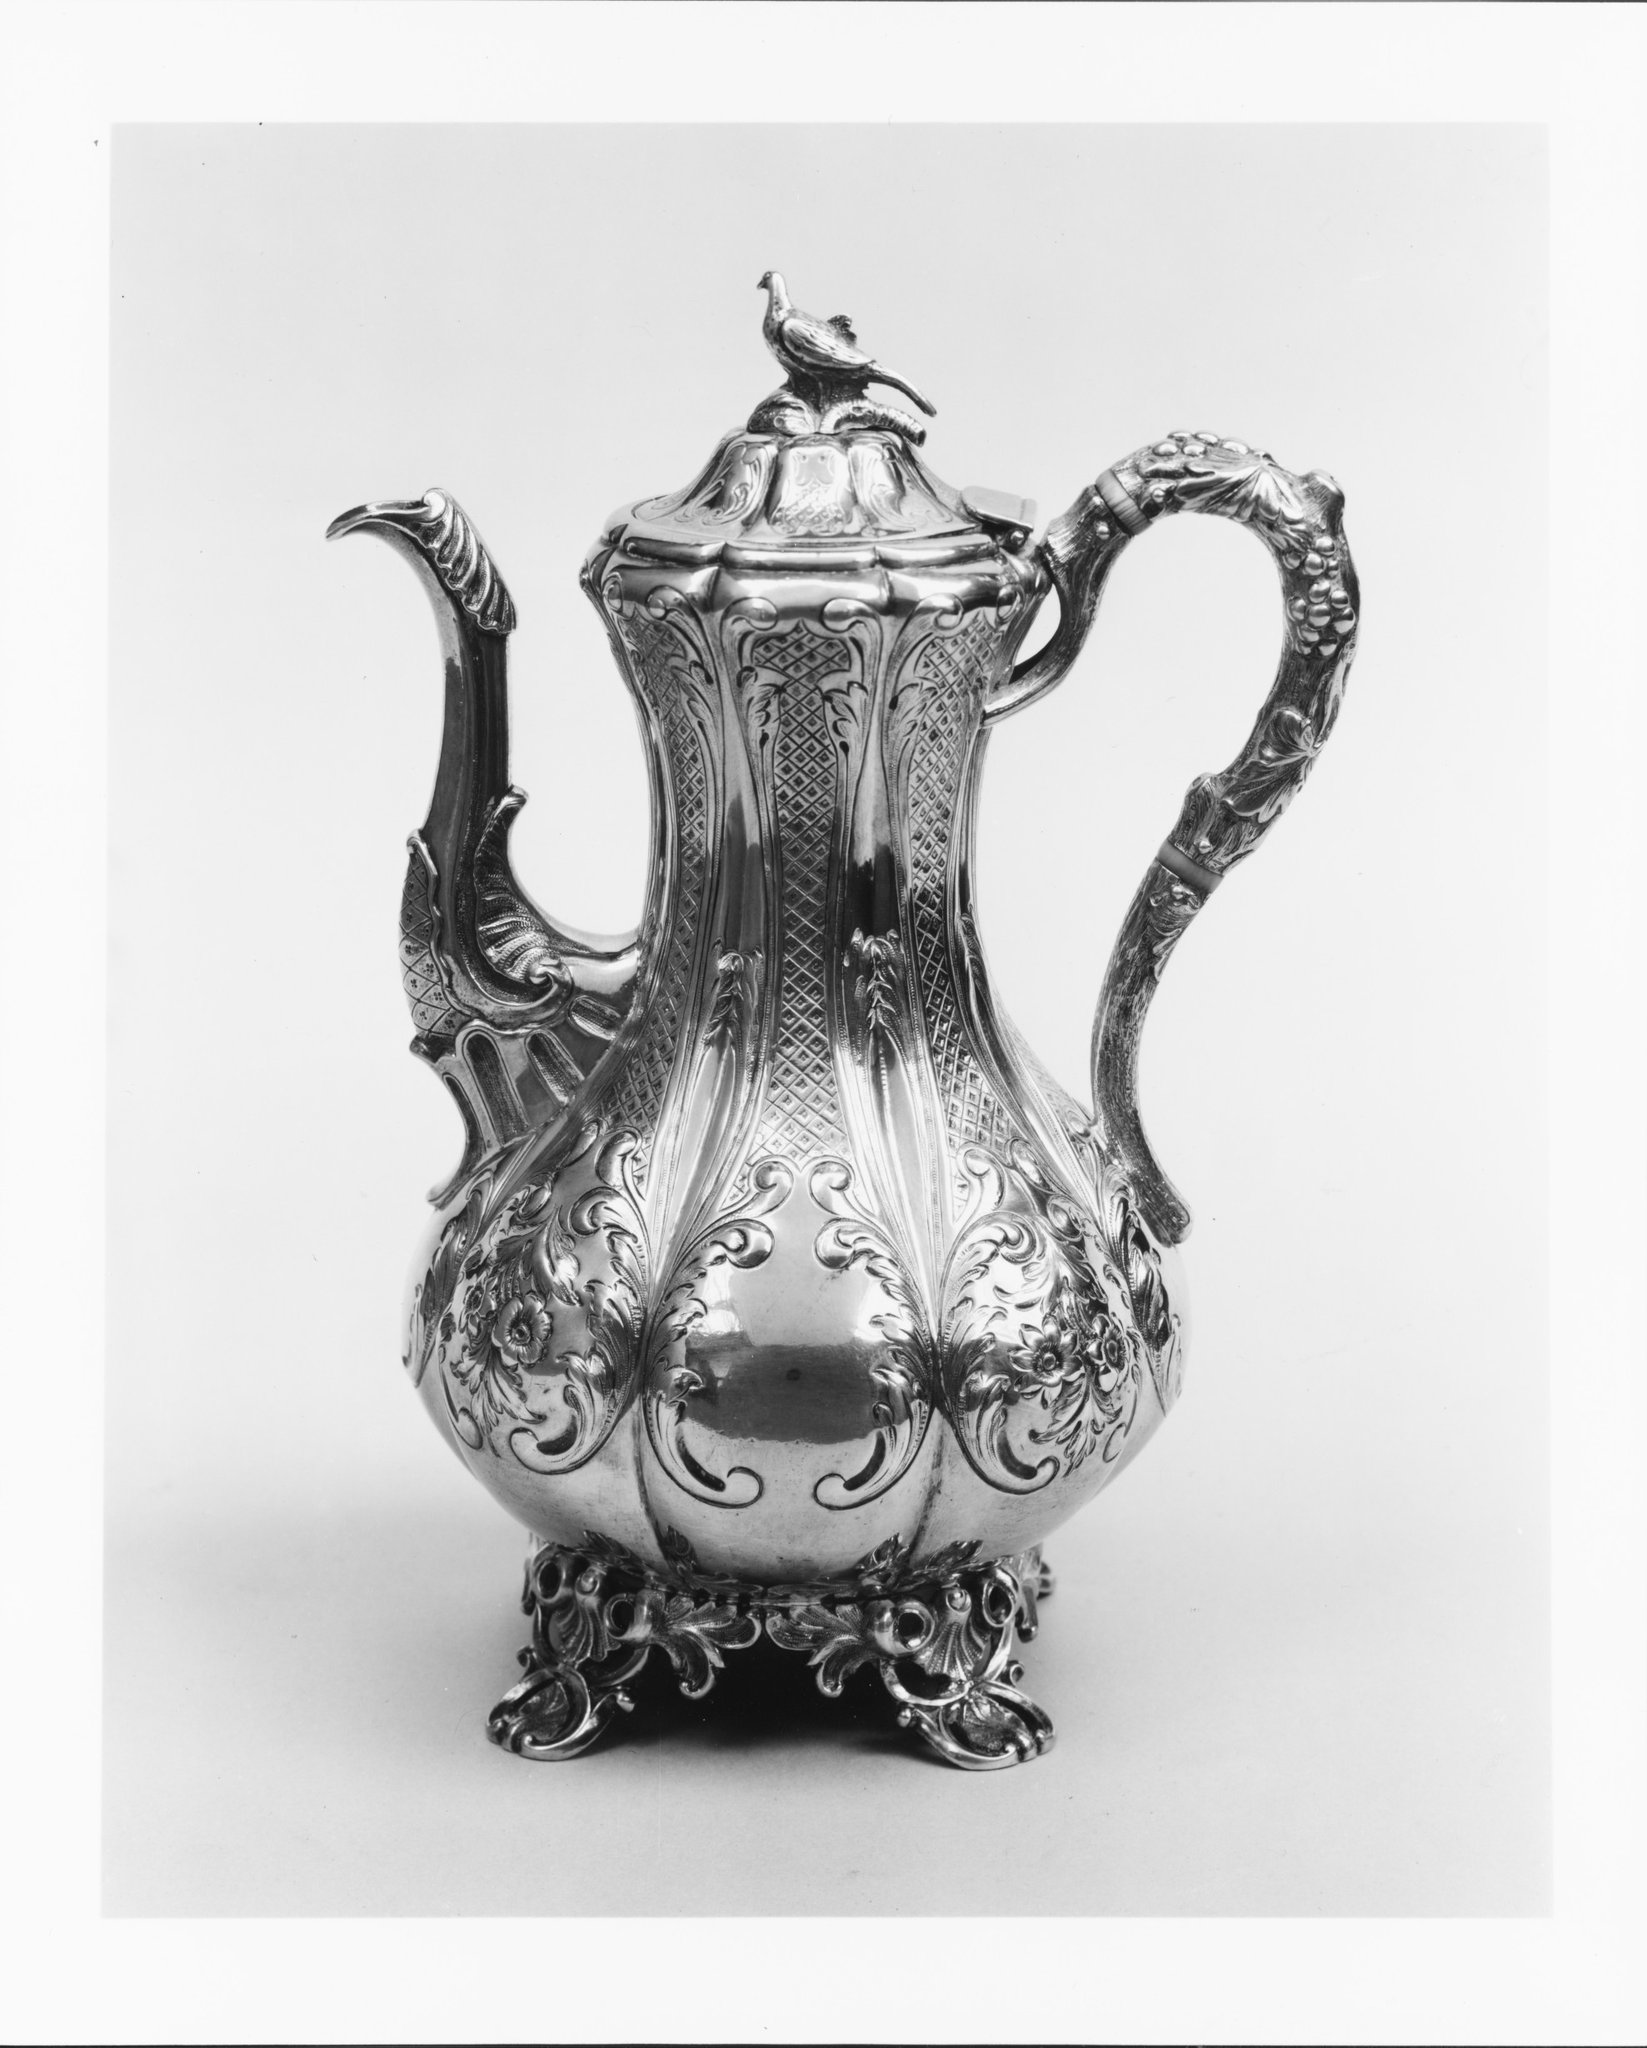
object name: milk pot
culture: american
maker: ball, tompkins and black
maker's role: retailer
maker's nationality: american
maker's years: 1839-1851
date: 1848-1851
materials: ivory, silver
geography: united states